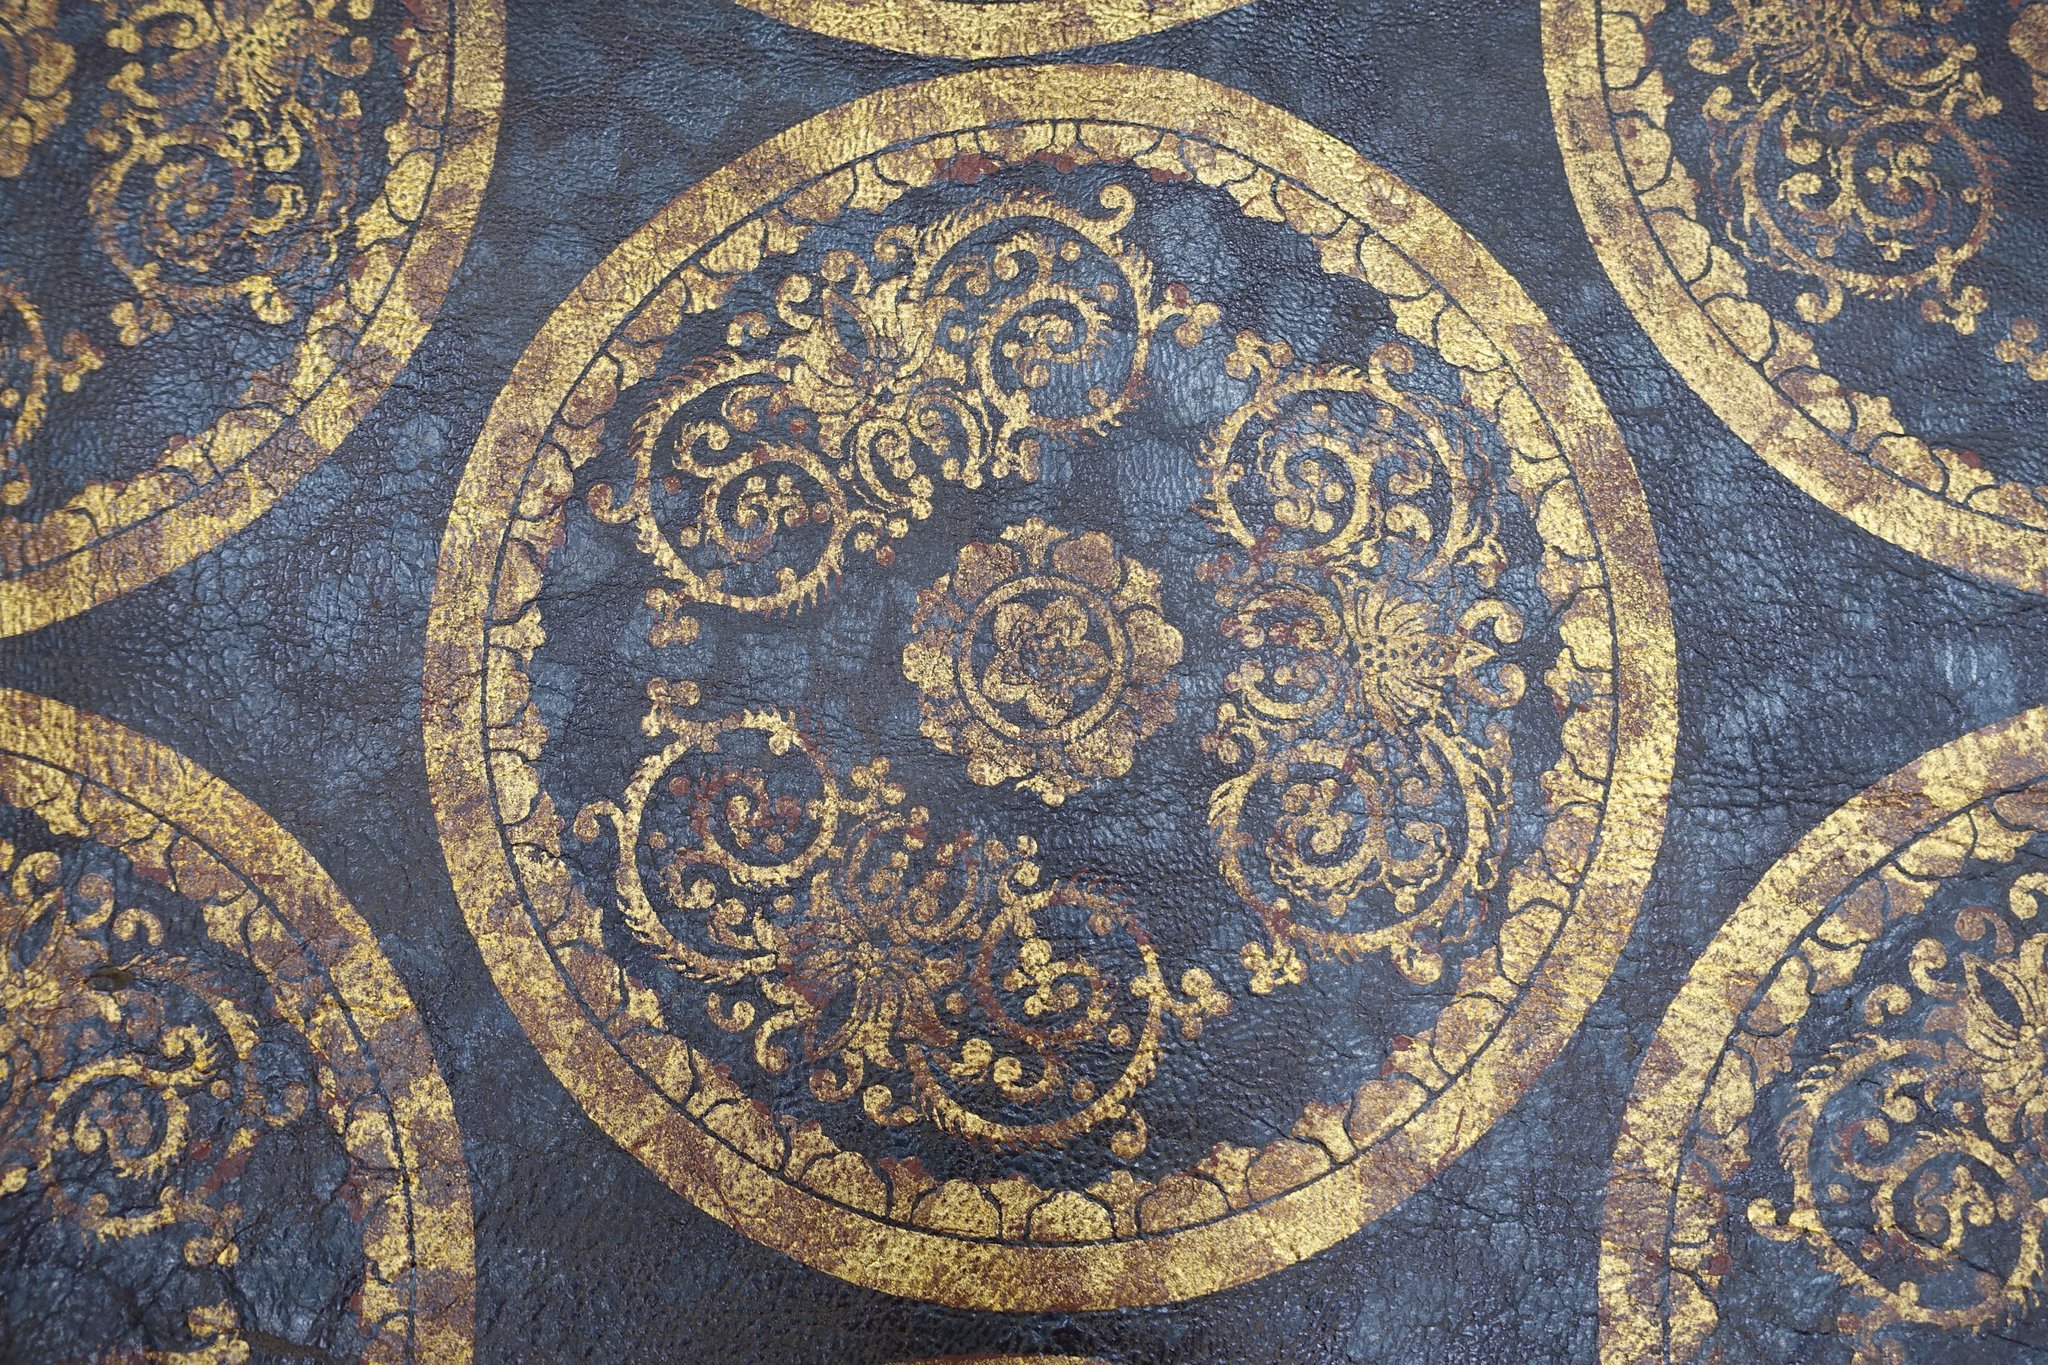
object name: panel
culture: japanese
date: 1801-1900